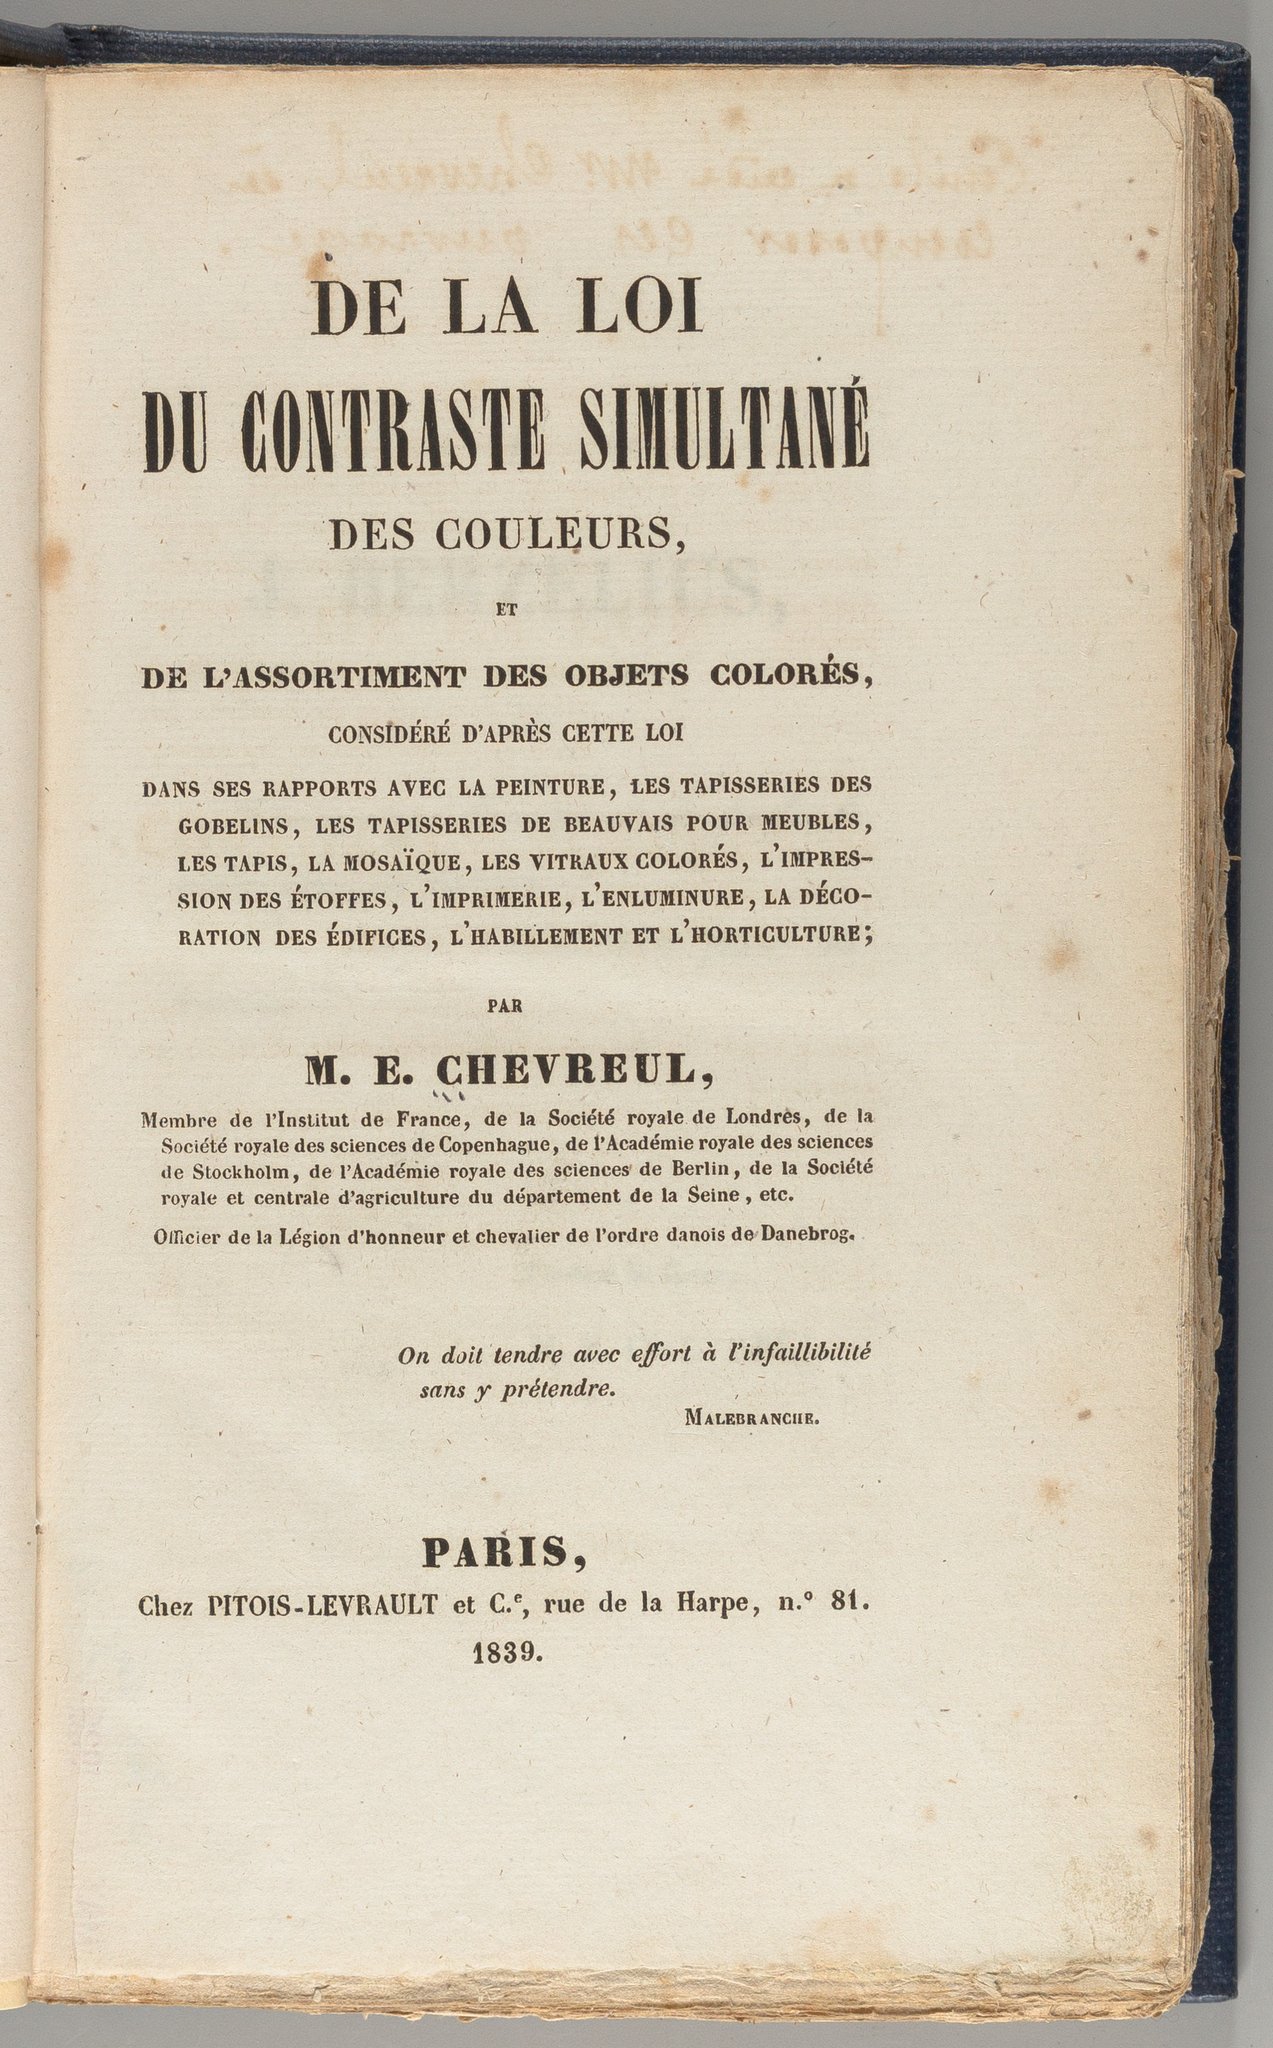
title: De la loi du contraste simultané des couleurs, et de l'assortiment des objets colorés, considéré d'après cette loi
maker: michel eugène chevreul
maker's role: author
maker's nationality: french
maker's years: 1786-1889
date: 1839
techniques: bookbinding, lithograph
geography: france